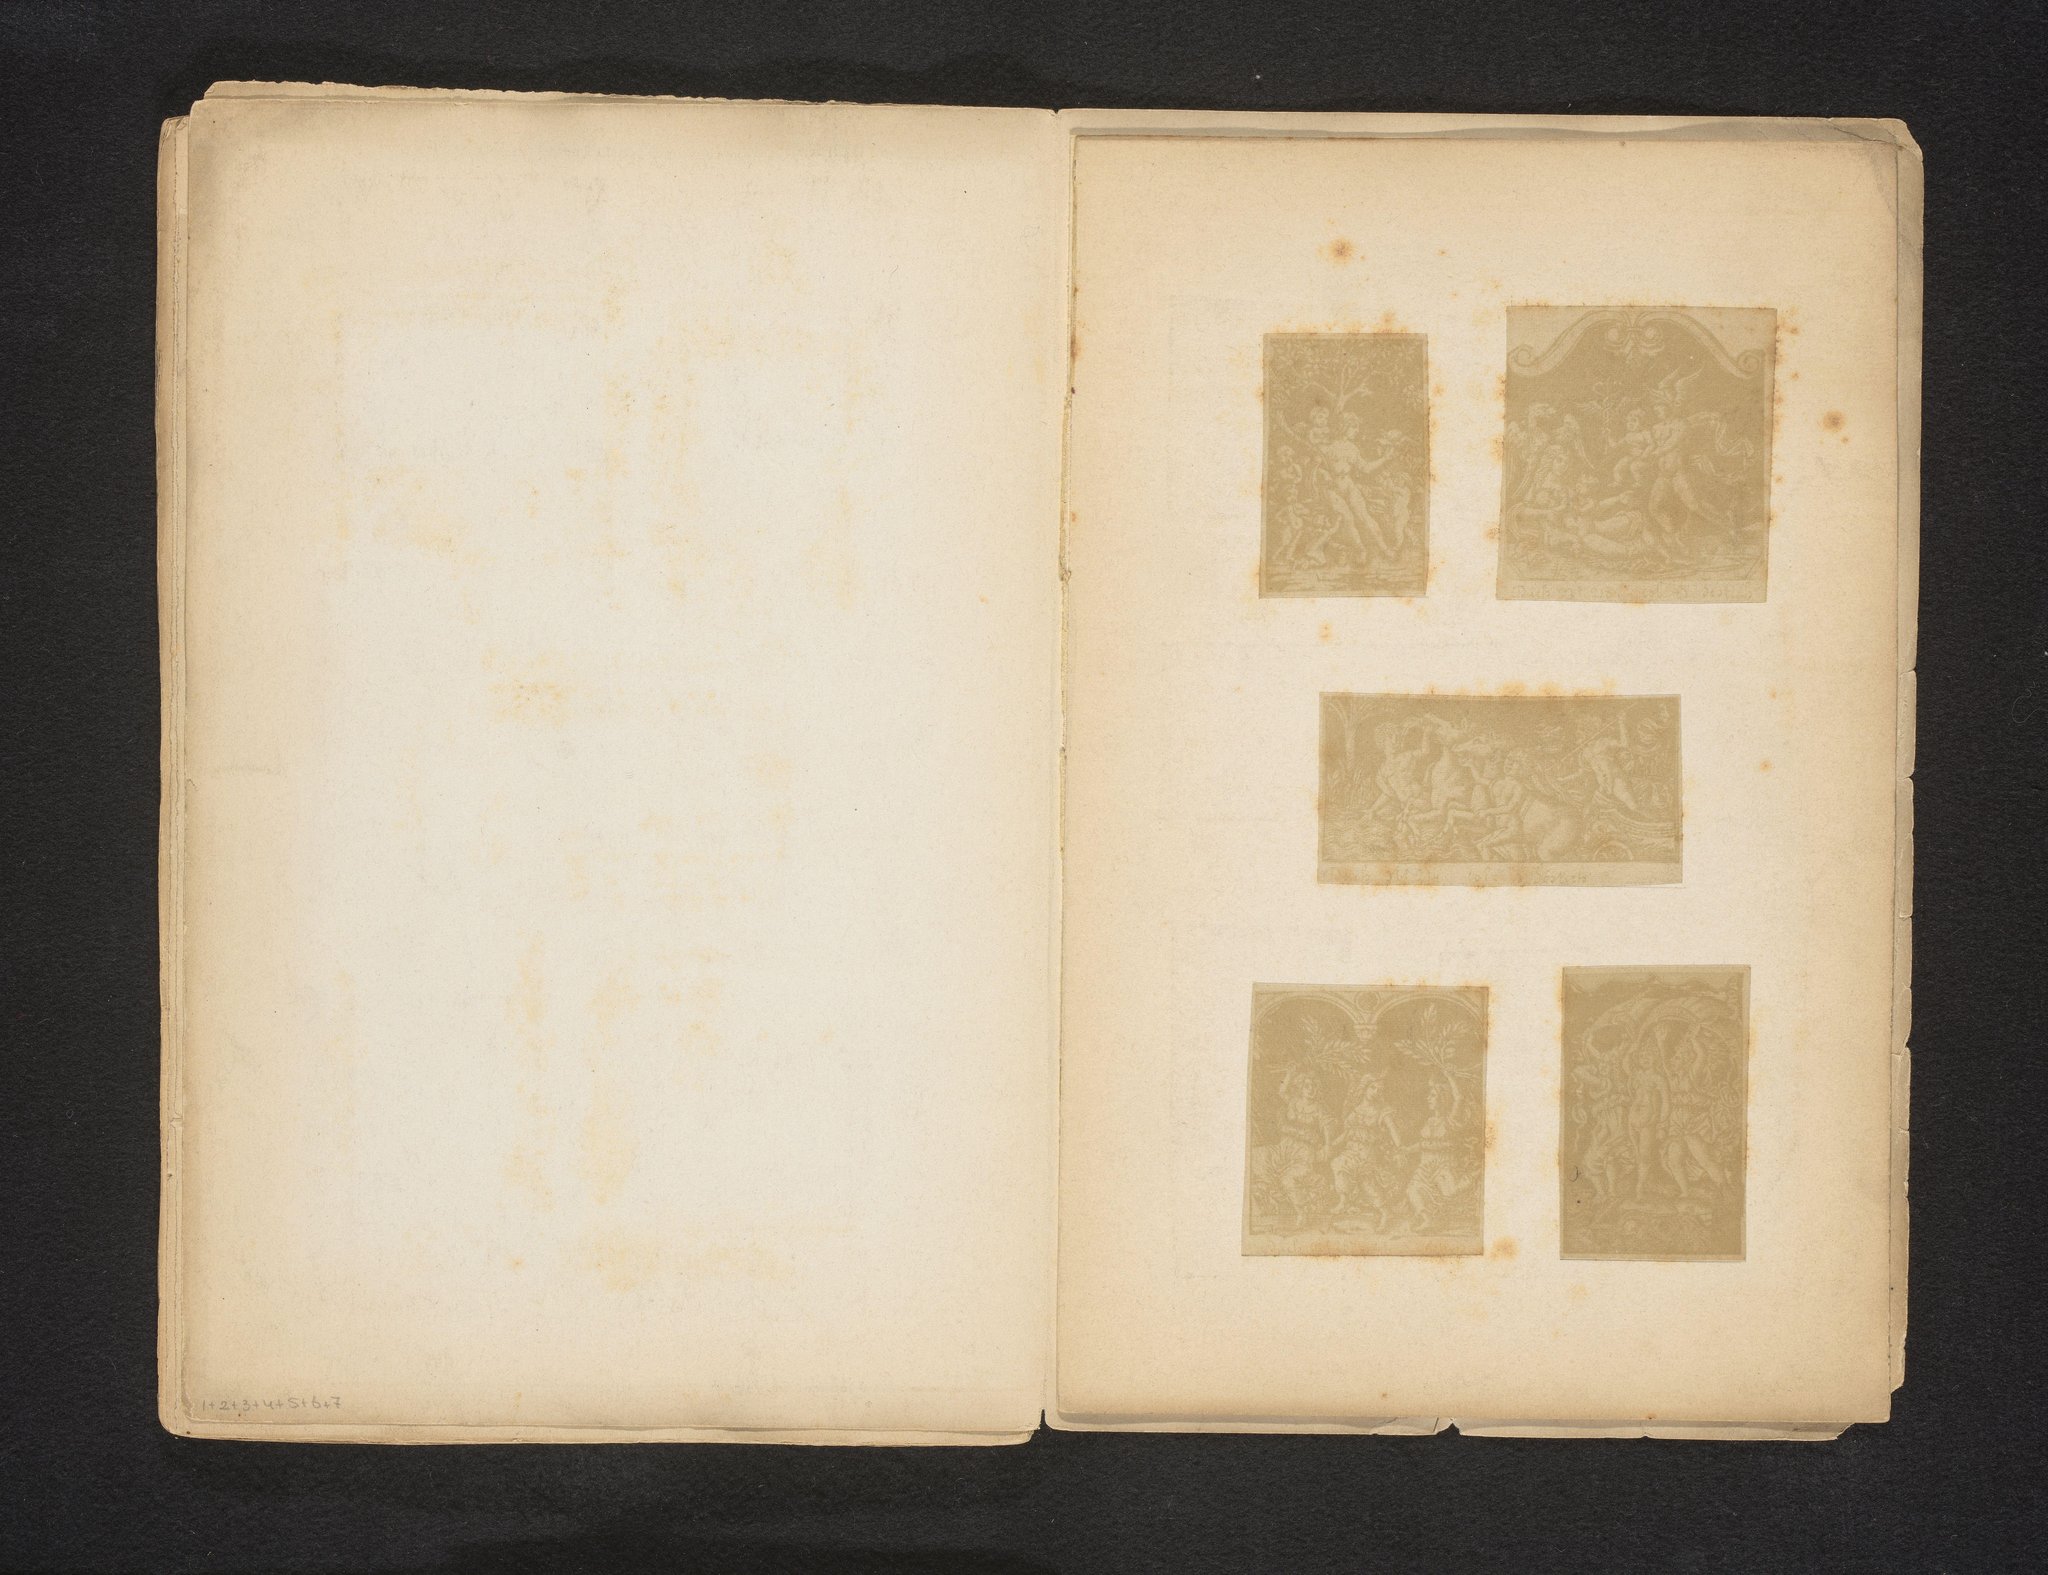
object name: page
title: Fotoreproductie van een prent van drie dansende vrouwen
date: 1852-1857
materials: photographic support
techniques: salted paper print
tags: adult woman, dancing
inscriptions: inscription: ‘Duch. No 28[7 - col. V. Sestich]’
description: Foto op blad met vijf foto's op derde ongenummerde pagina na pagina 60.